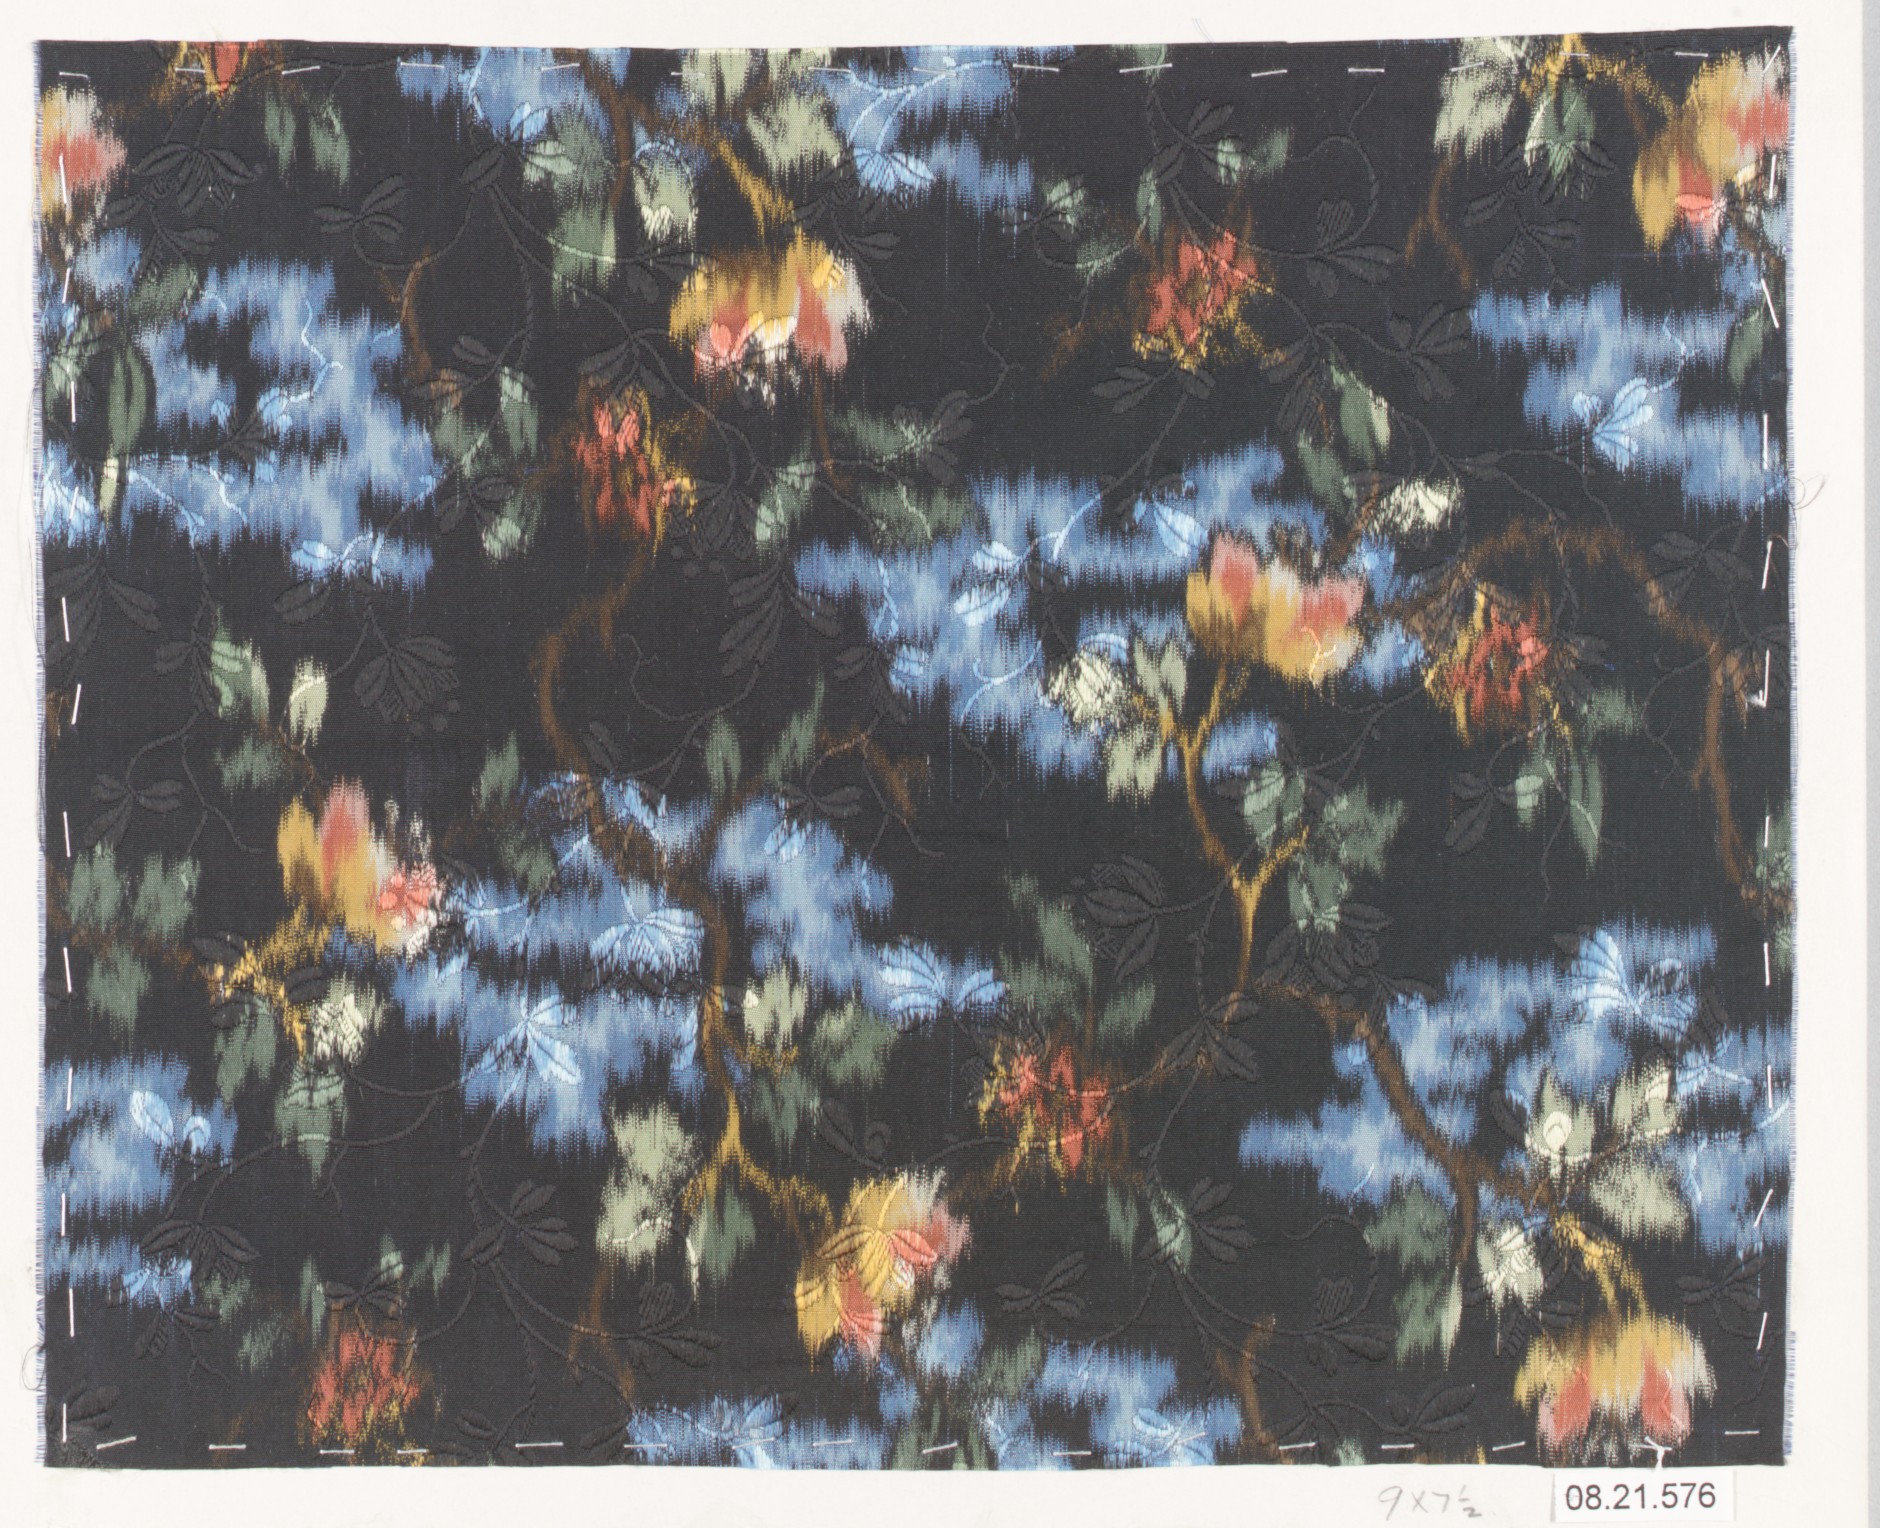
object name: textile sample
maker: Anonymous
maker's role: designer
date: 1900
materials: silk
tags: flowers